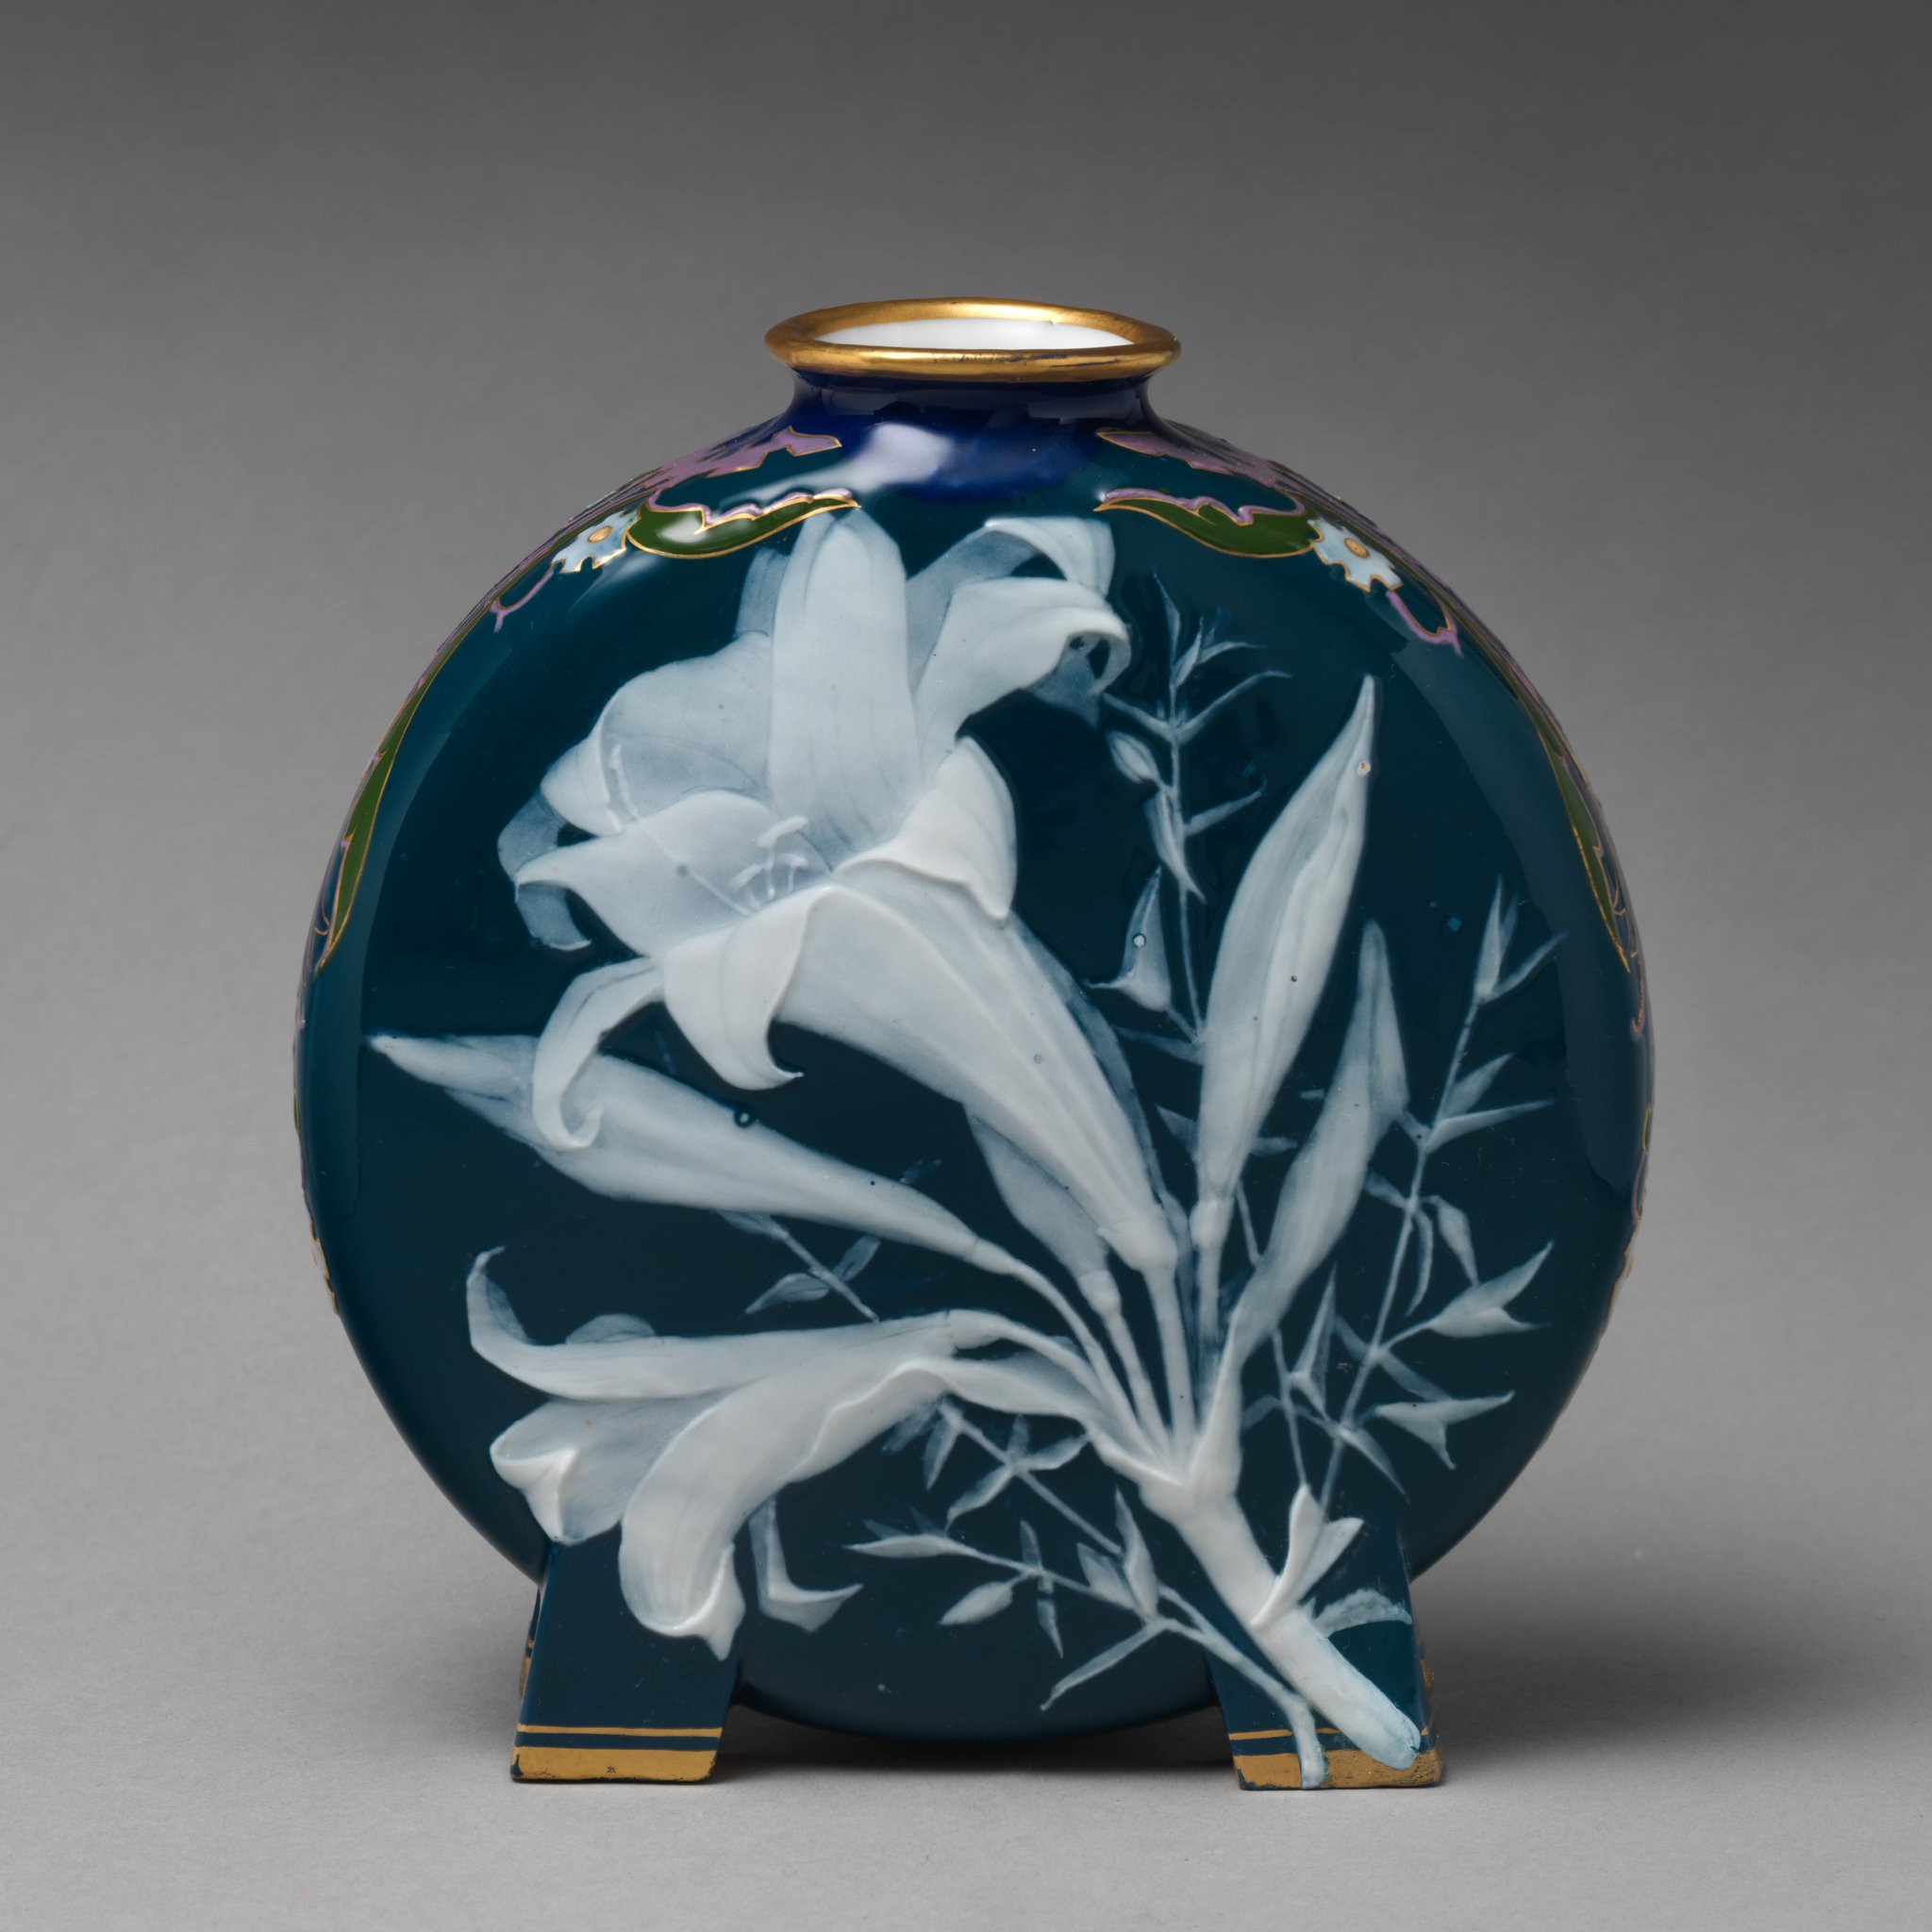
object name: moon flask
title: Moon flask with lily or floral motif (one of a pair)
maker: minton(s)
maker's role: maker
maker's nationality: british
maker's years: 1793-2001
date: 1872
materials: bone china, enamel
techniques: gilding